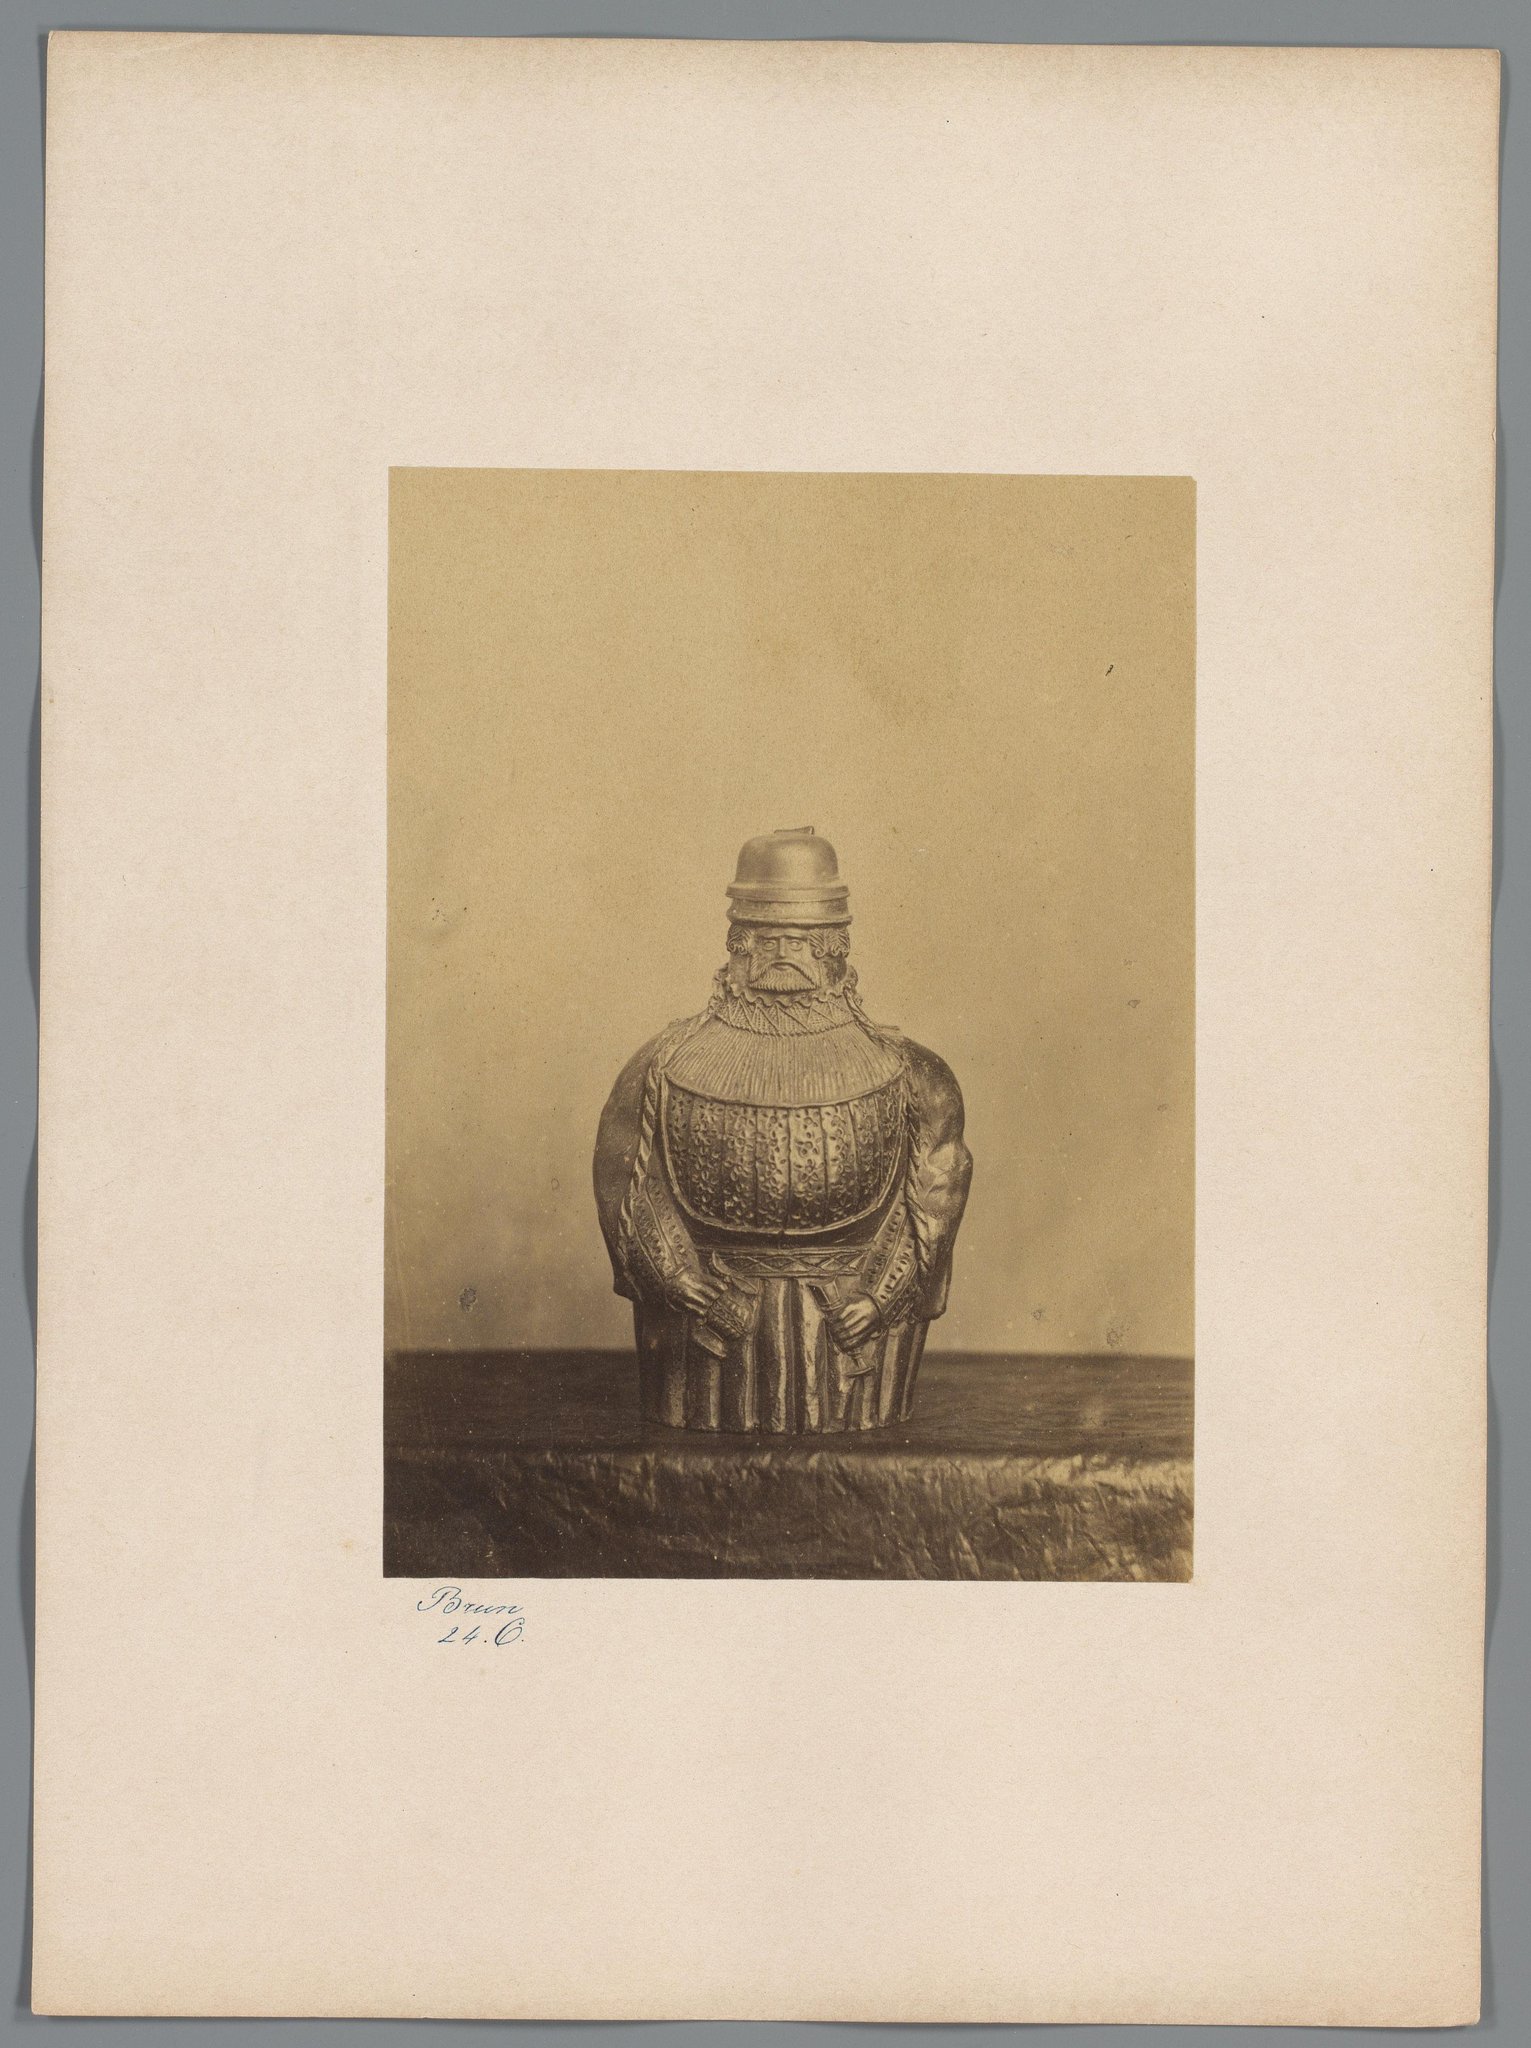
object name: photograph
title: Aardewerken vaas in de vorm van een man uit de collectie van W. de Weckherlin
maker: Anonymous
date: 1860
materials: paper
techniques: albumen print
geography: the hague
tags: container of ceramics: jar, jug, pot, vase, the hague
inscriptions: inscription: ‘Brun/ 24.G.’